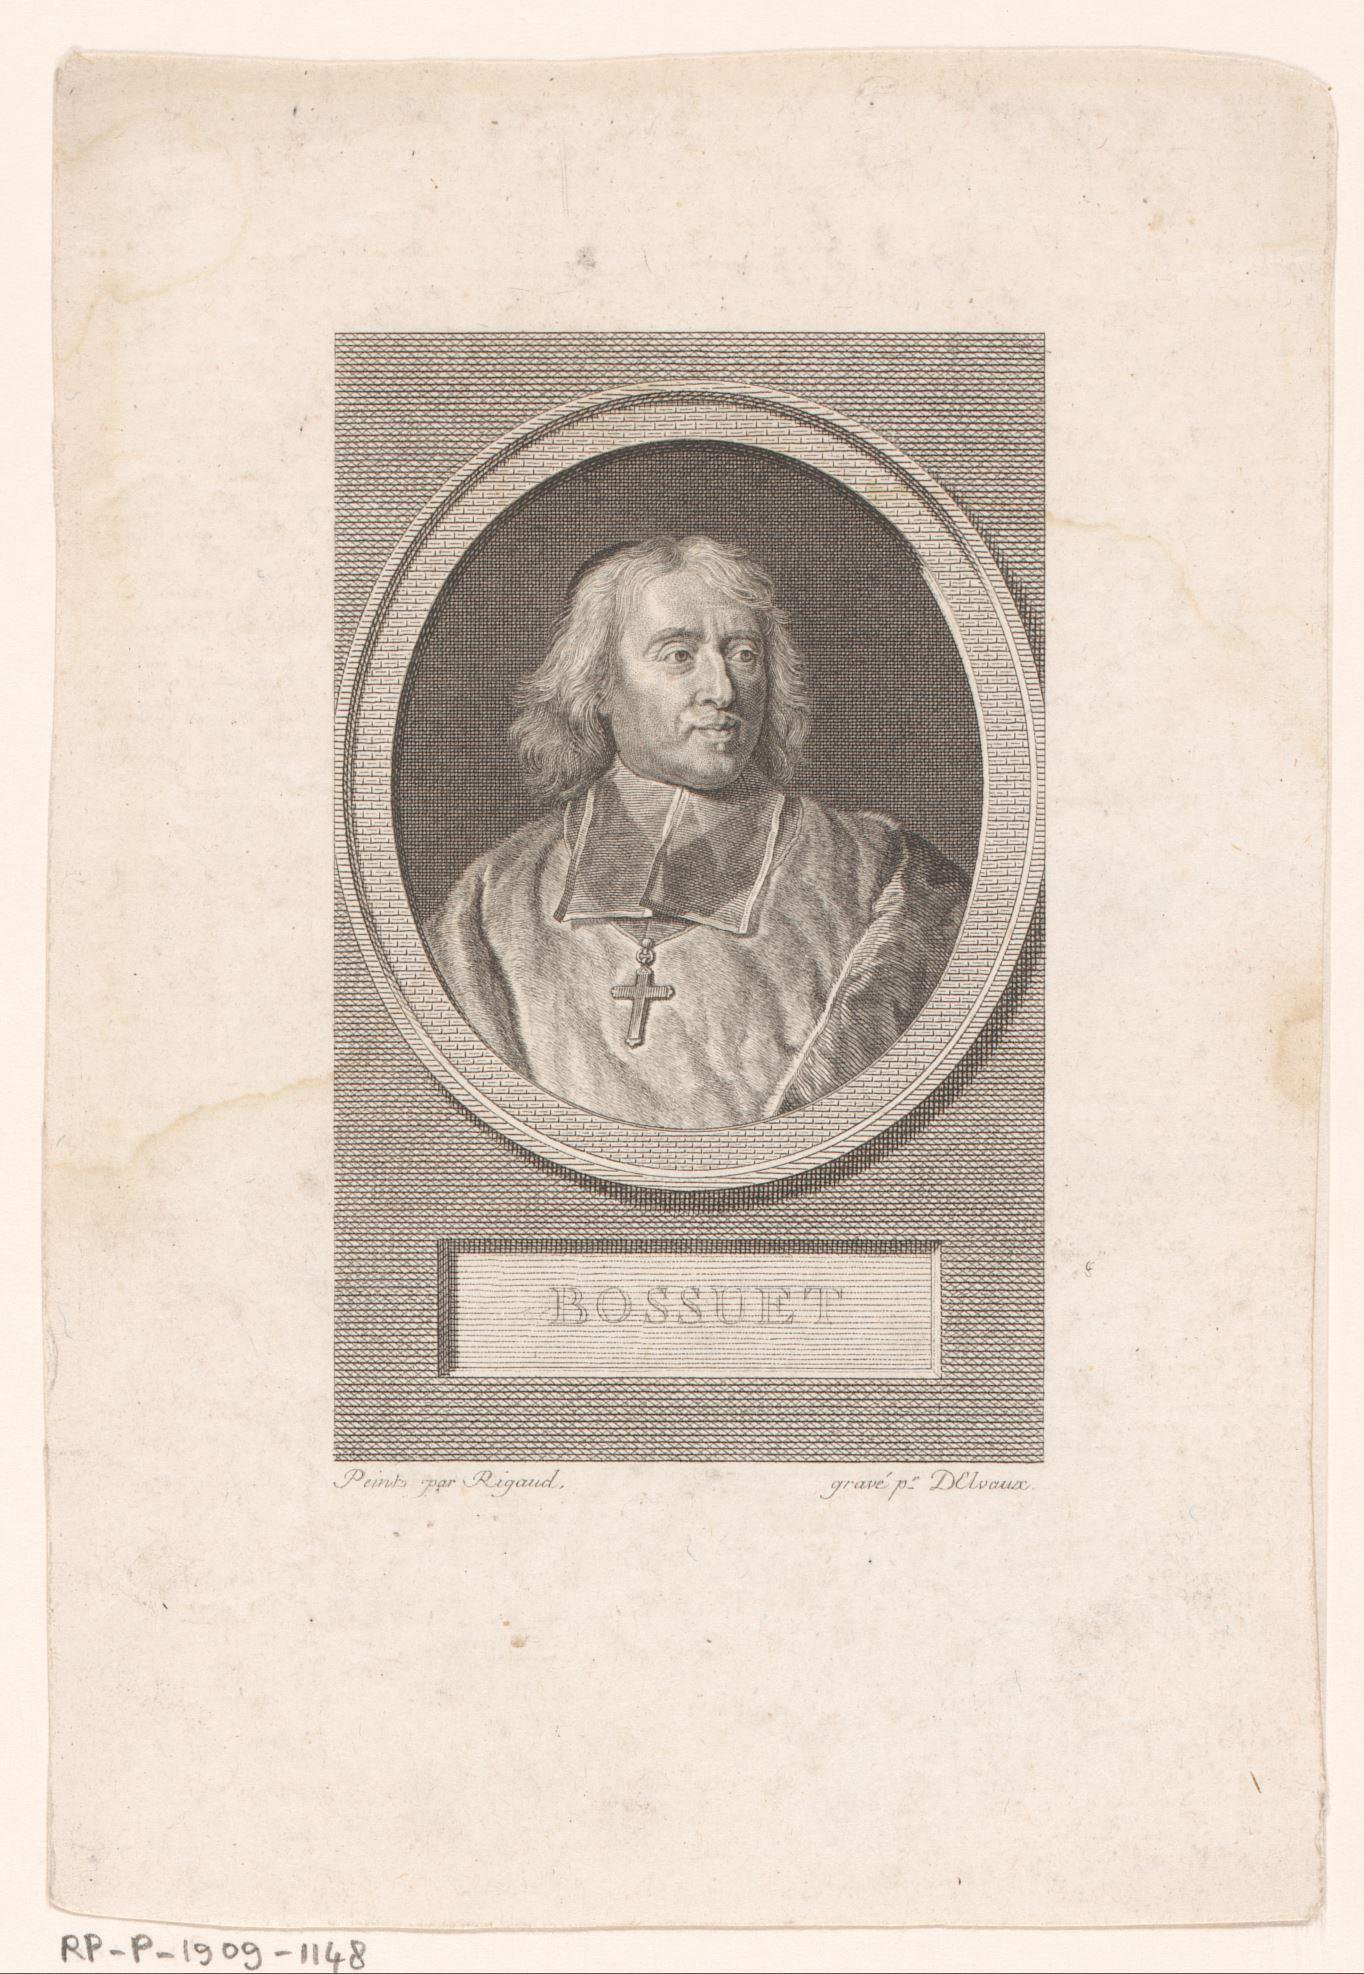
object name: print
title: Portret van Jacques Bénigne Bossuet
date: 1760-1823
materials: paper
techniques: engraving, etching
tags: paris, archbishop, bishop, etc. (roman catholic), historical persons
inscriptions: collector's mark: Lugt 2228